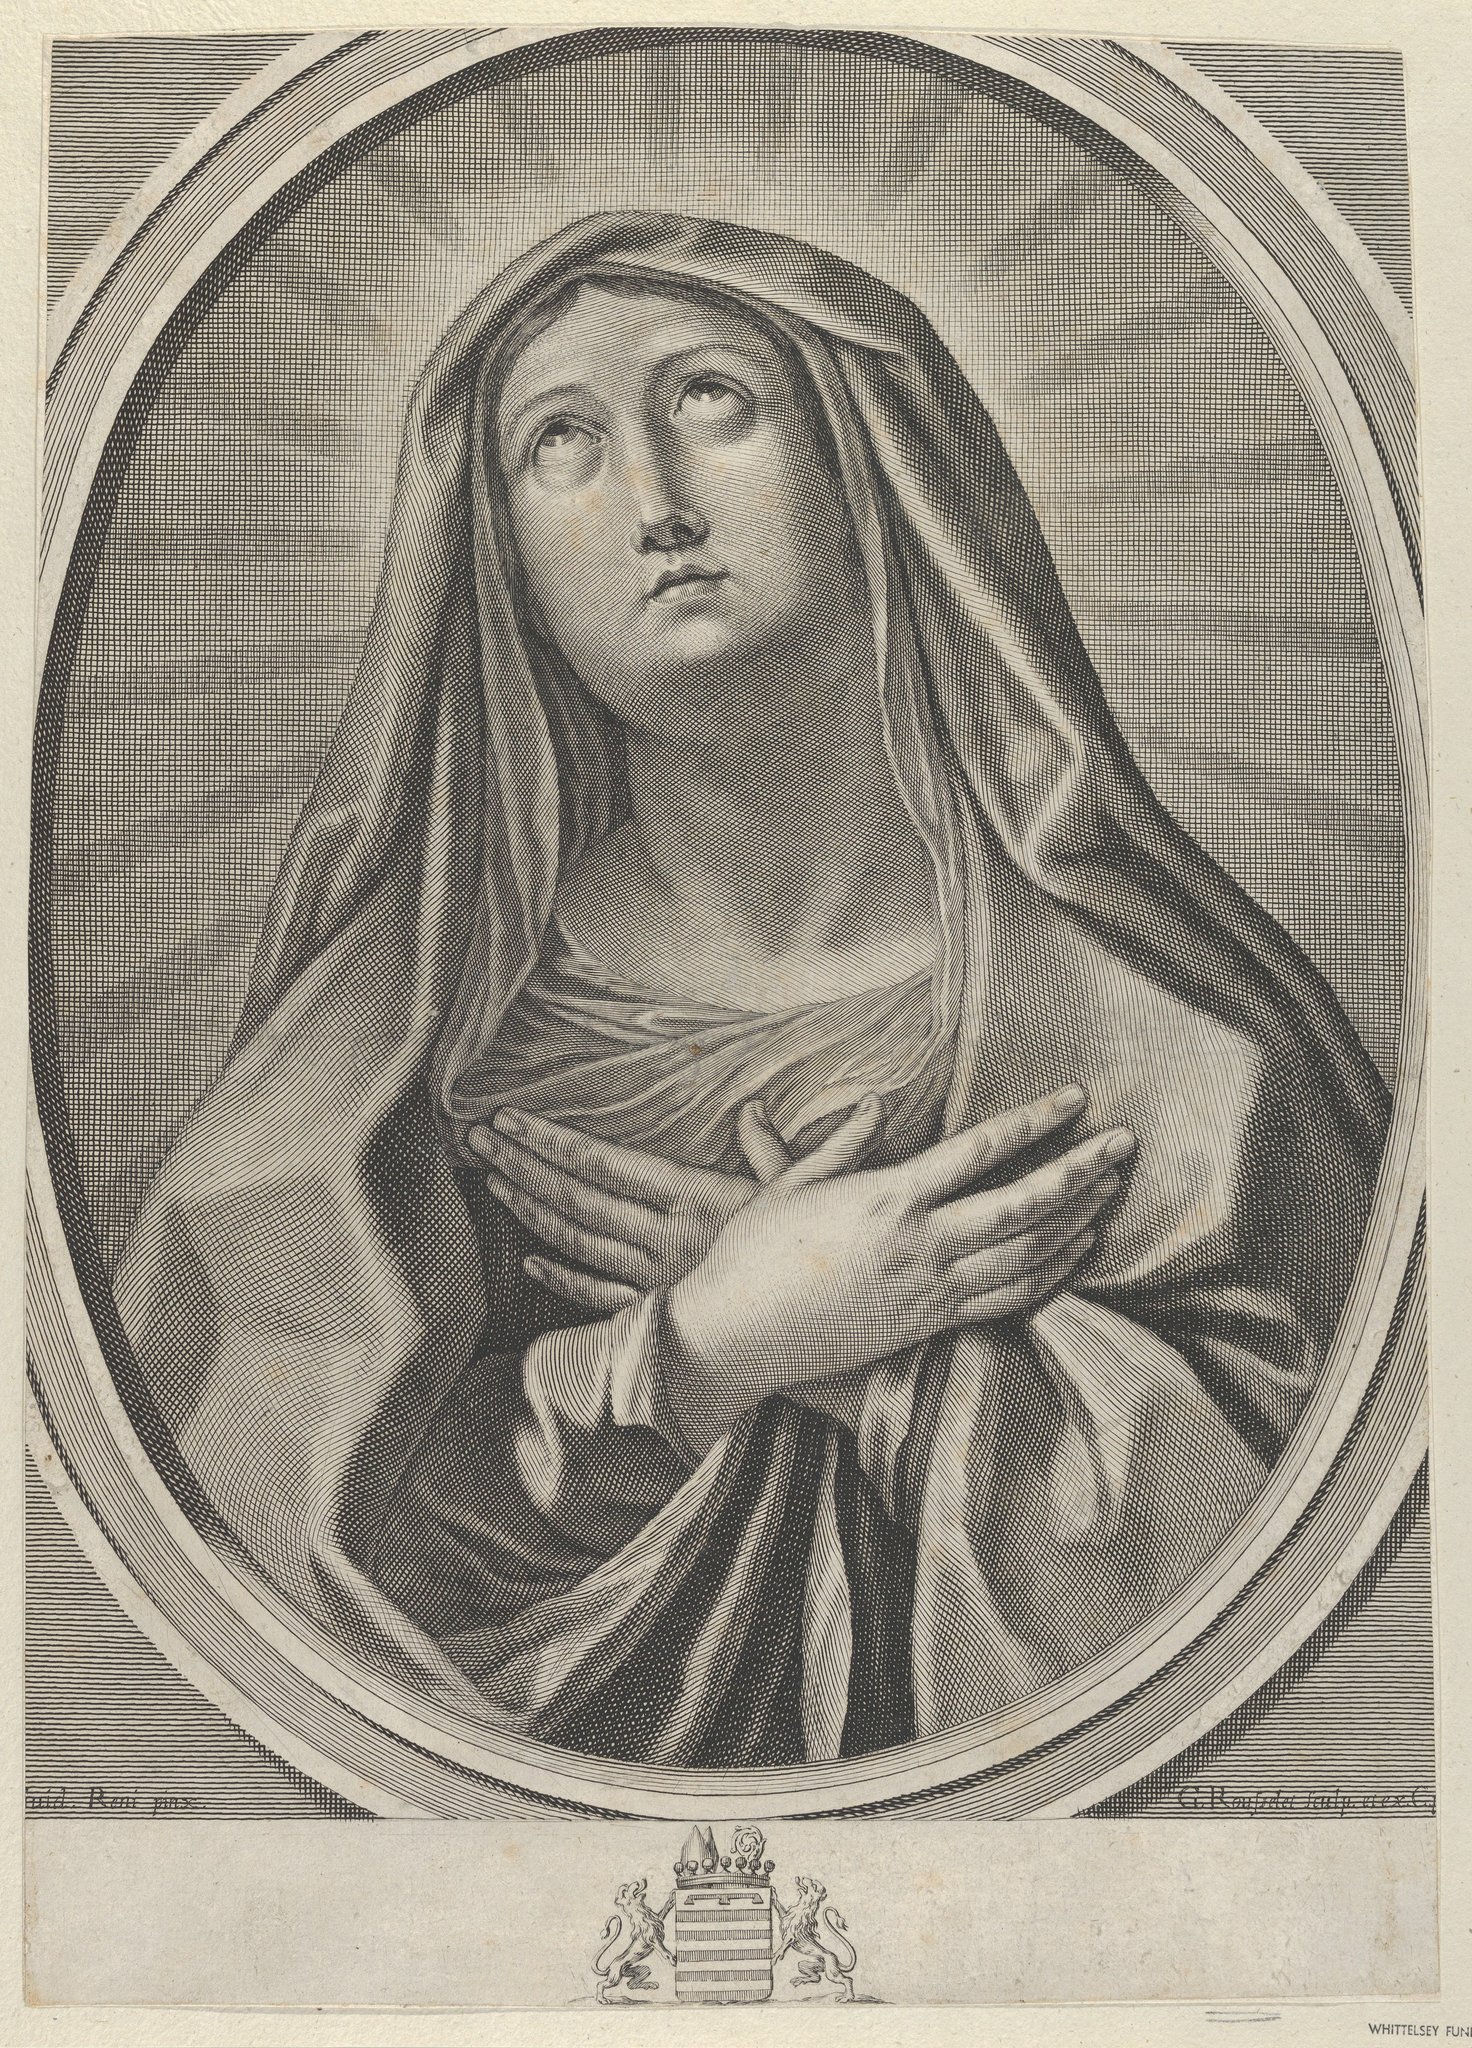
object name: print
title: The Virgin with arms crossed over her chest, looking up to the left, in an oval frame, after Reni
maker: gilles rousselet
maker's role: artist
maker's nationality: french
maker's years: 1614-1686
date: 1640-1645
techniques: engraving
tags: virgin mary,coat of arms